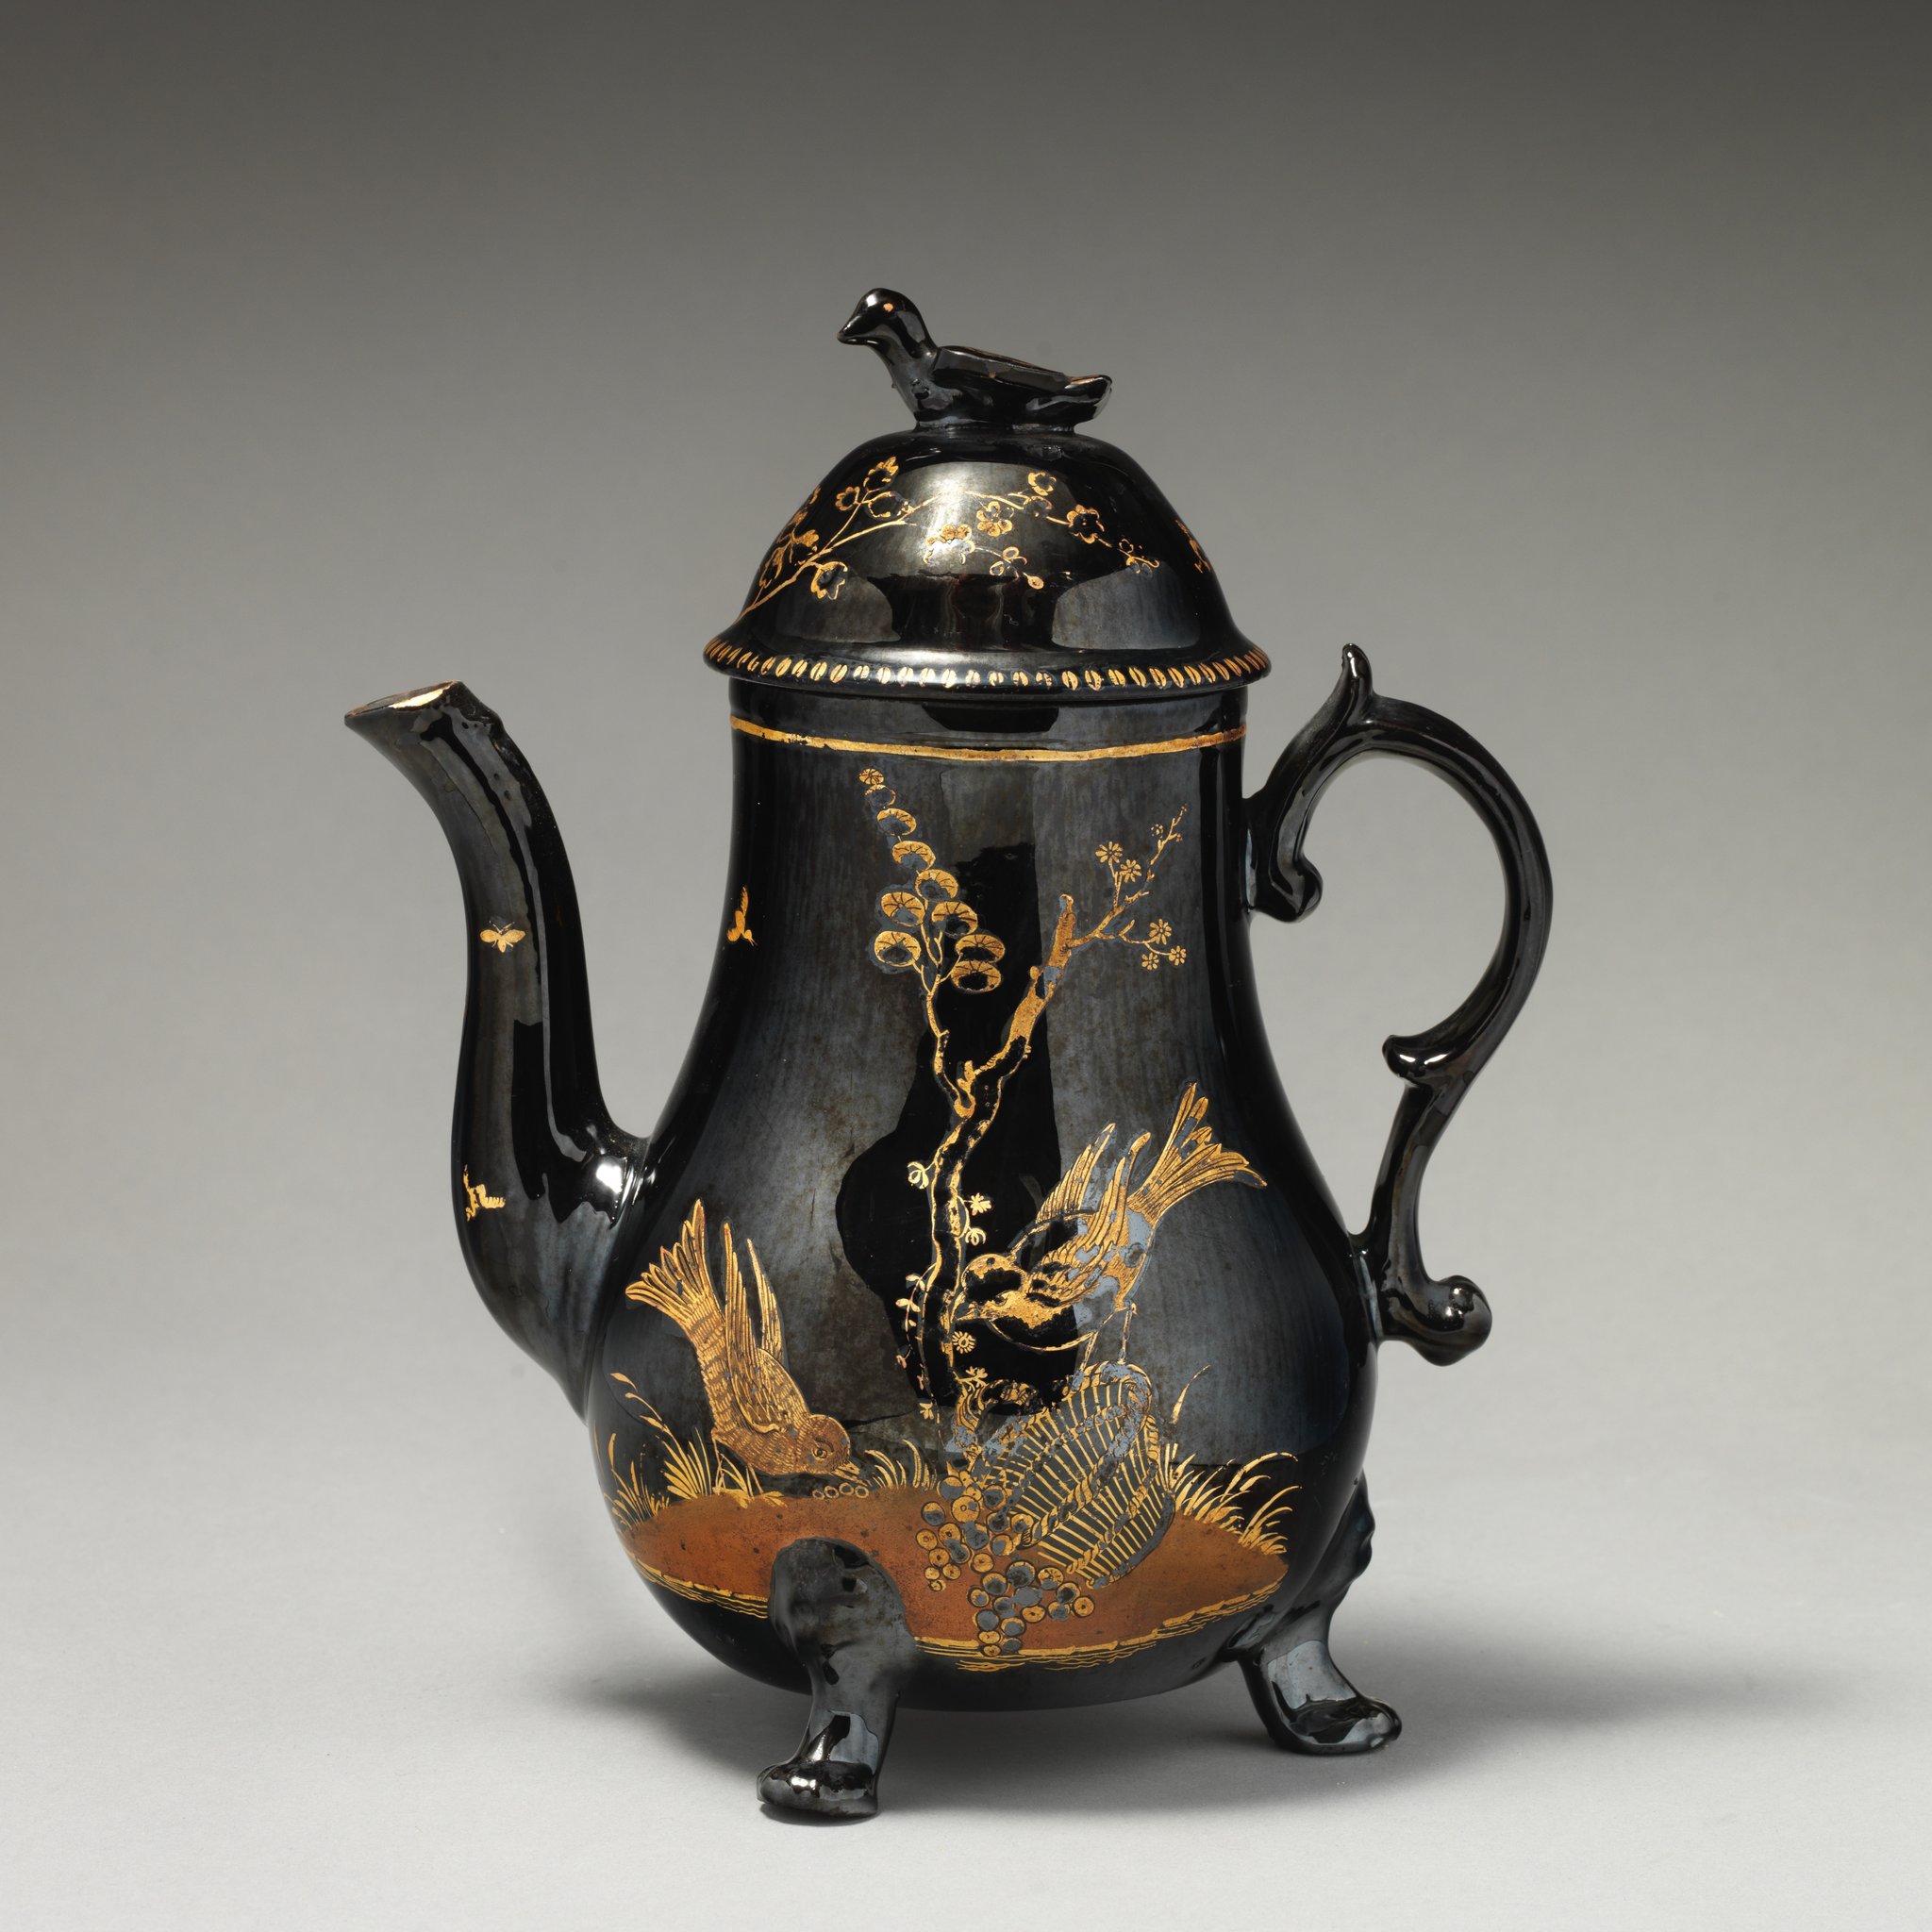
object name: coffeepot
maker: jackfield pottery, shropshire, england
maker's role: maker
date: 1701-1800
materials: earthenware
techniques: glazing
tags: birds